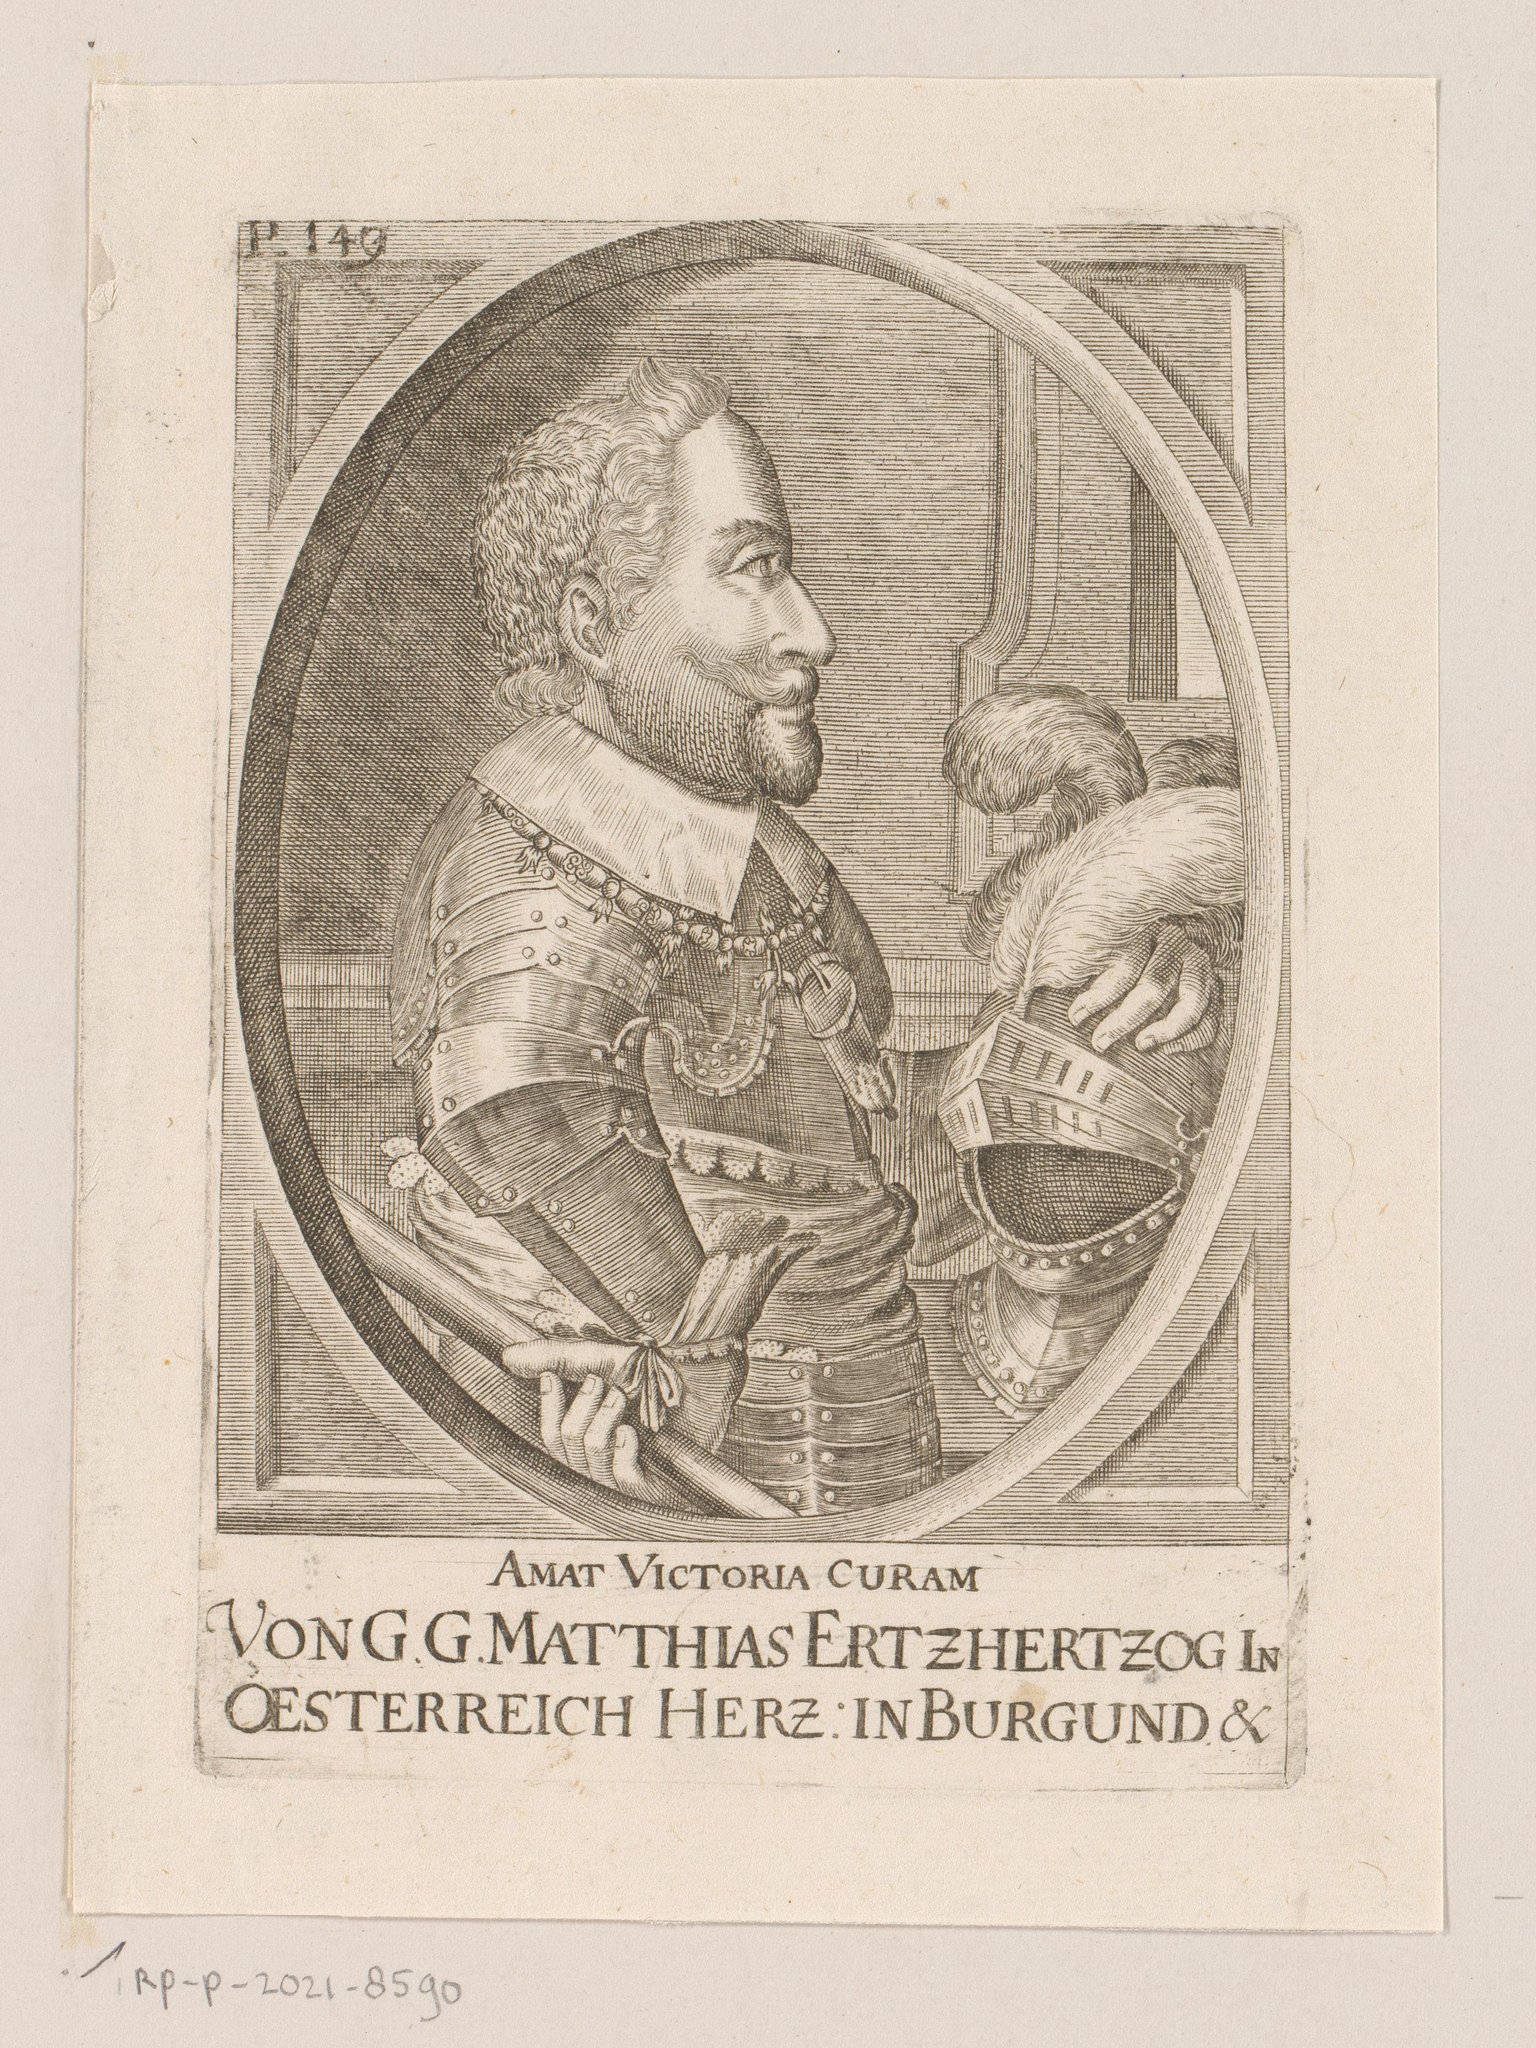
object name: book illustration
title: Portret van keizer Matthias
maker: Anonymous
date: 1650-1750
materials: paper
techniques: engraving, etching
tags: vienna, matthias van oostenrijk (rooms-duits keizer), armour, historical persons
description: Met onderschrift in het Duits. Linksboven: P. 149.